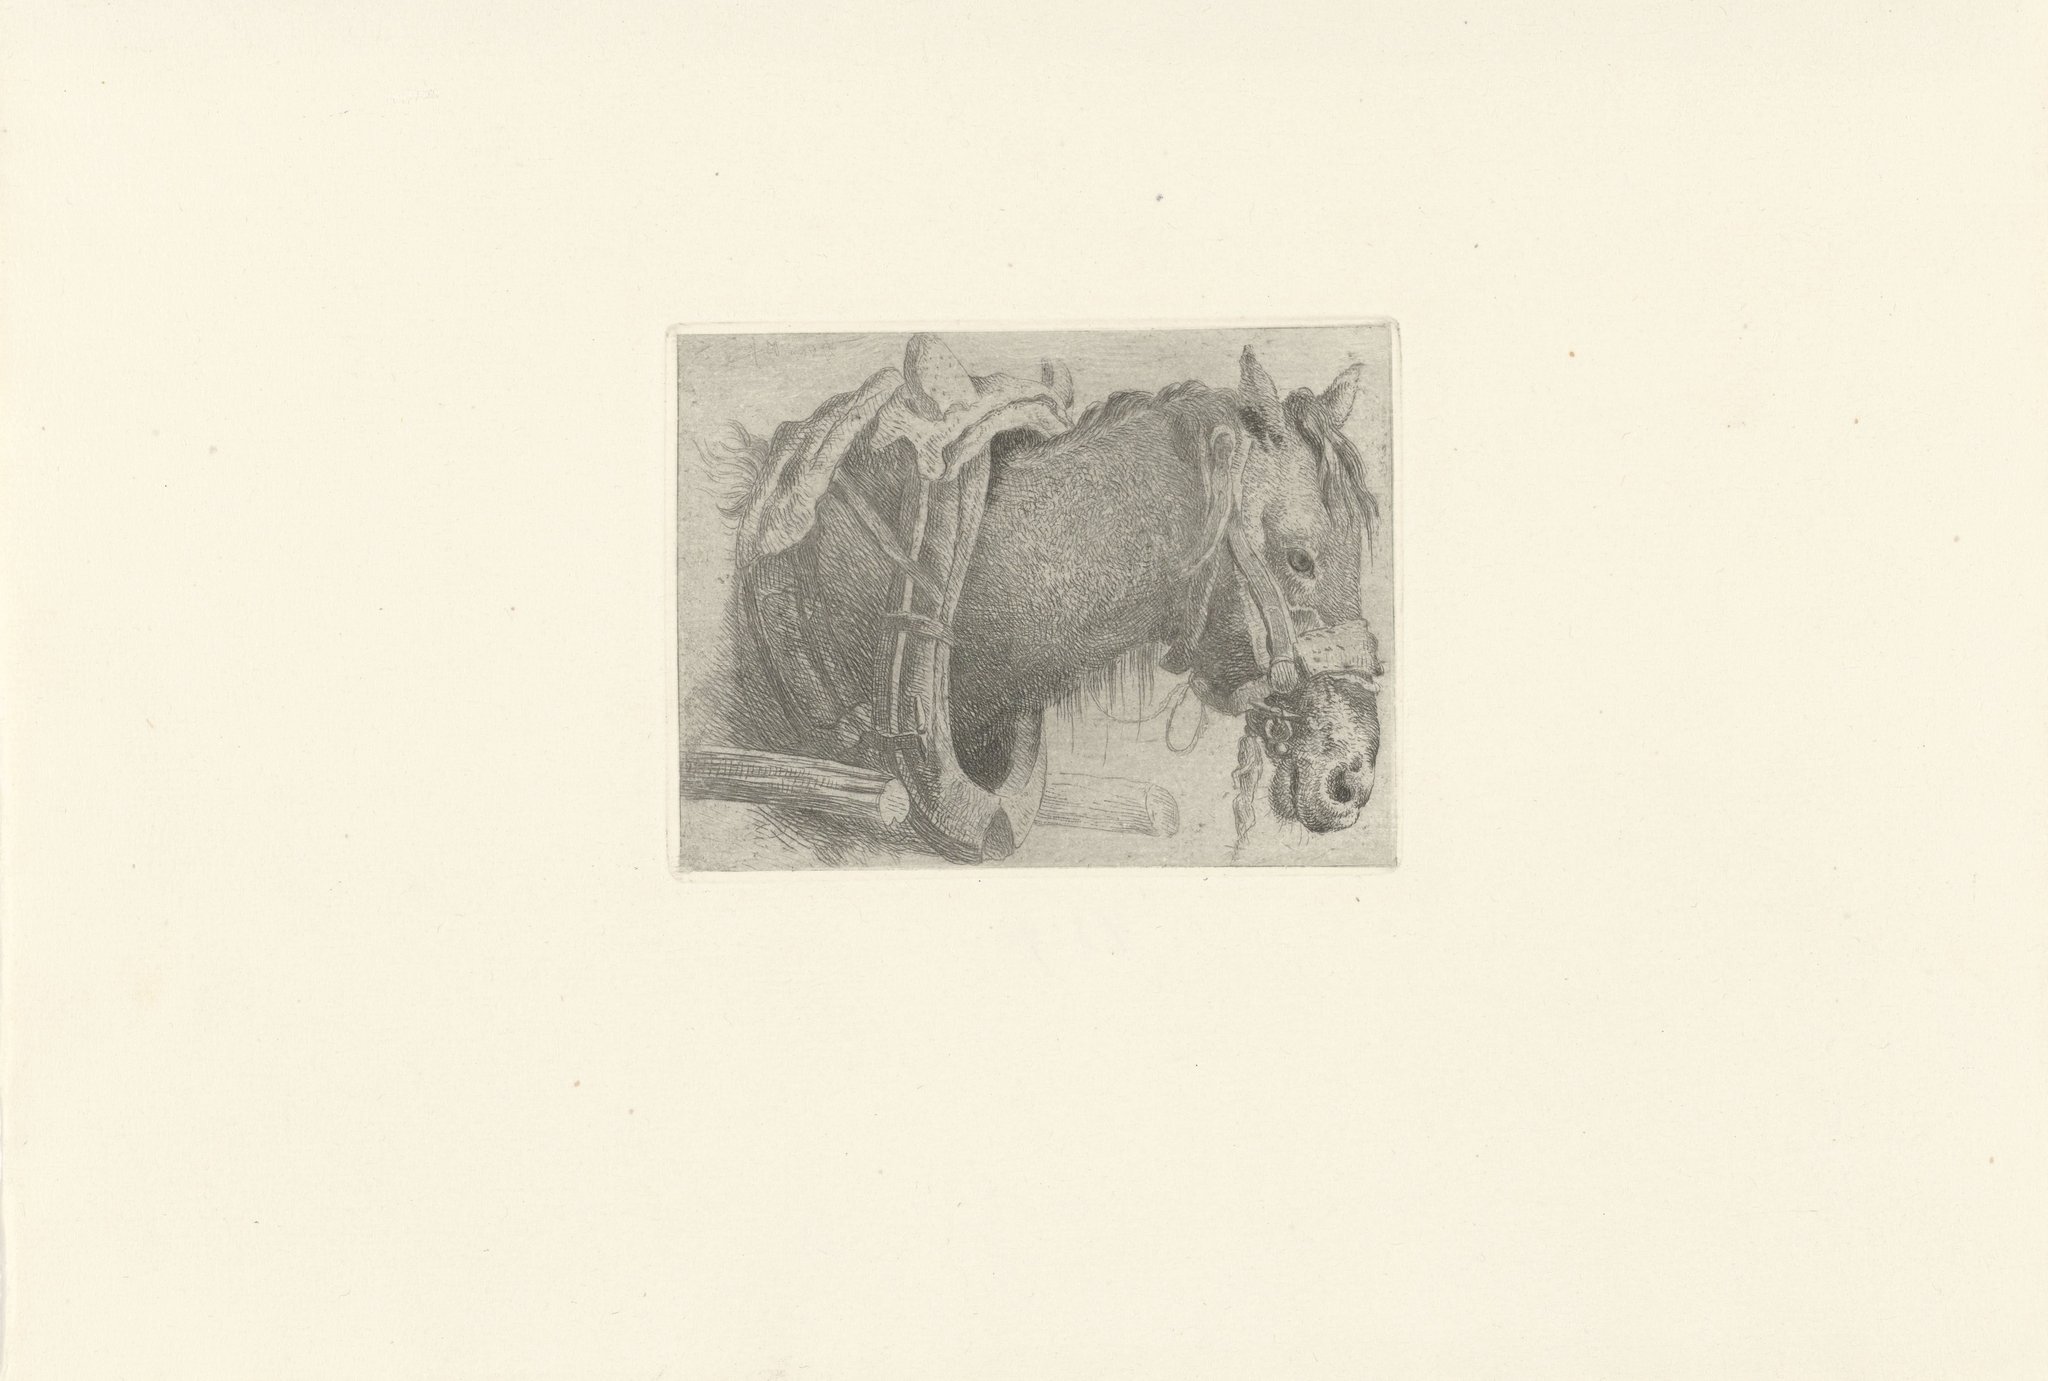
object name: print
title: Studie van een paardenkop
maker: pieter gerardus van os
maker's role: draughtsman, painter, print maker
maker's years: 1776-1839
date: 1791-1839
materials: paper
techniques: etching, intaglio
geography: netherlands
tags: horse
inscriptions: collector's mark: Lugt 2228